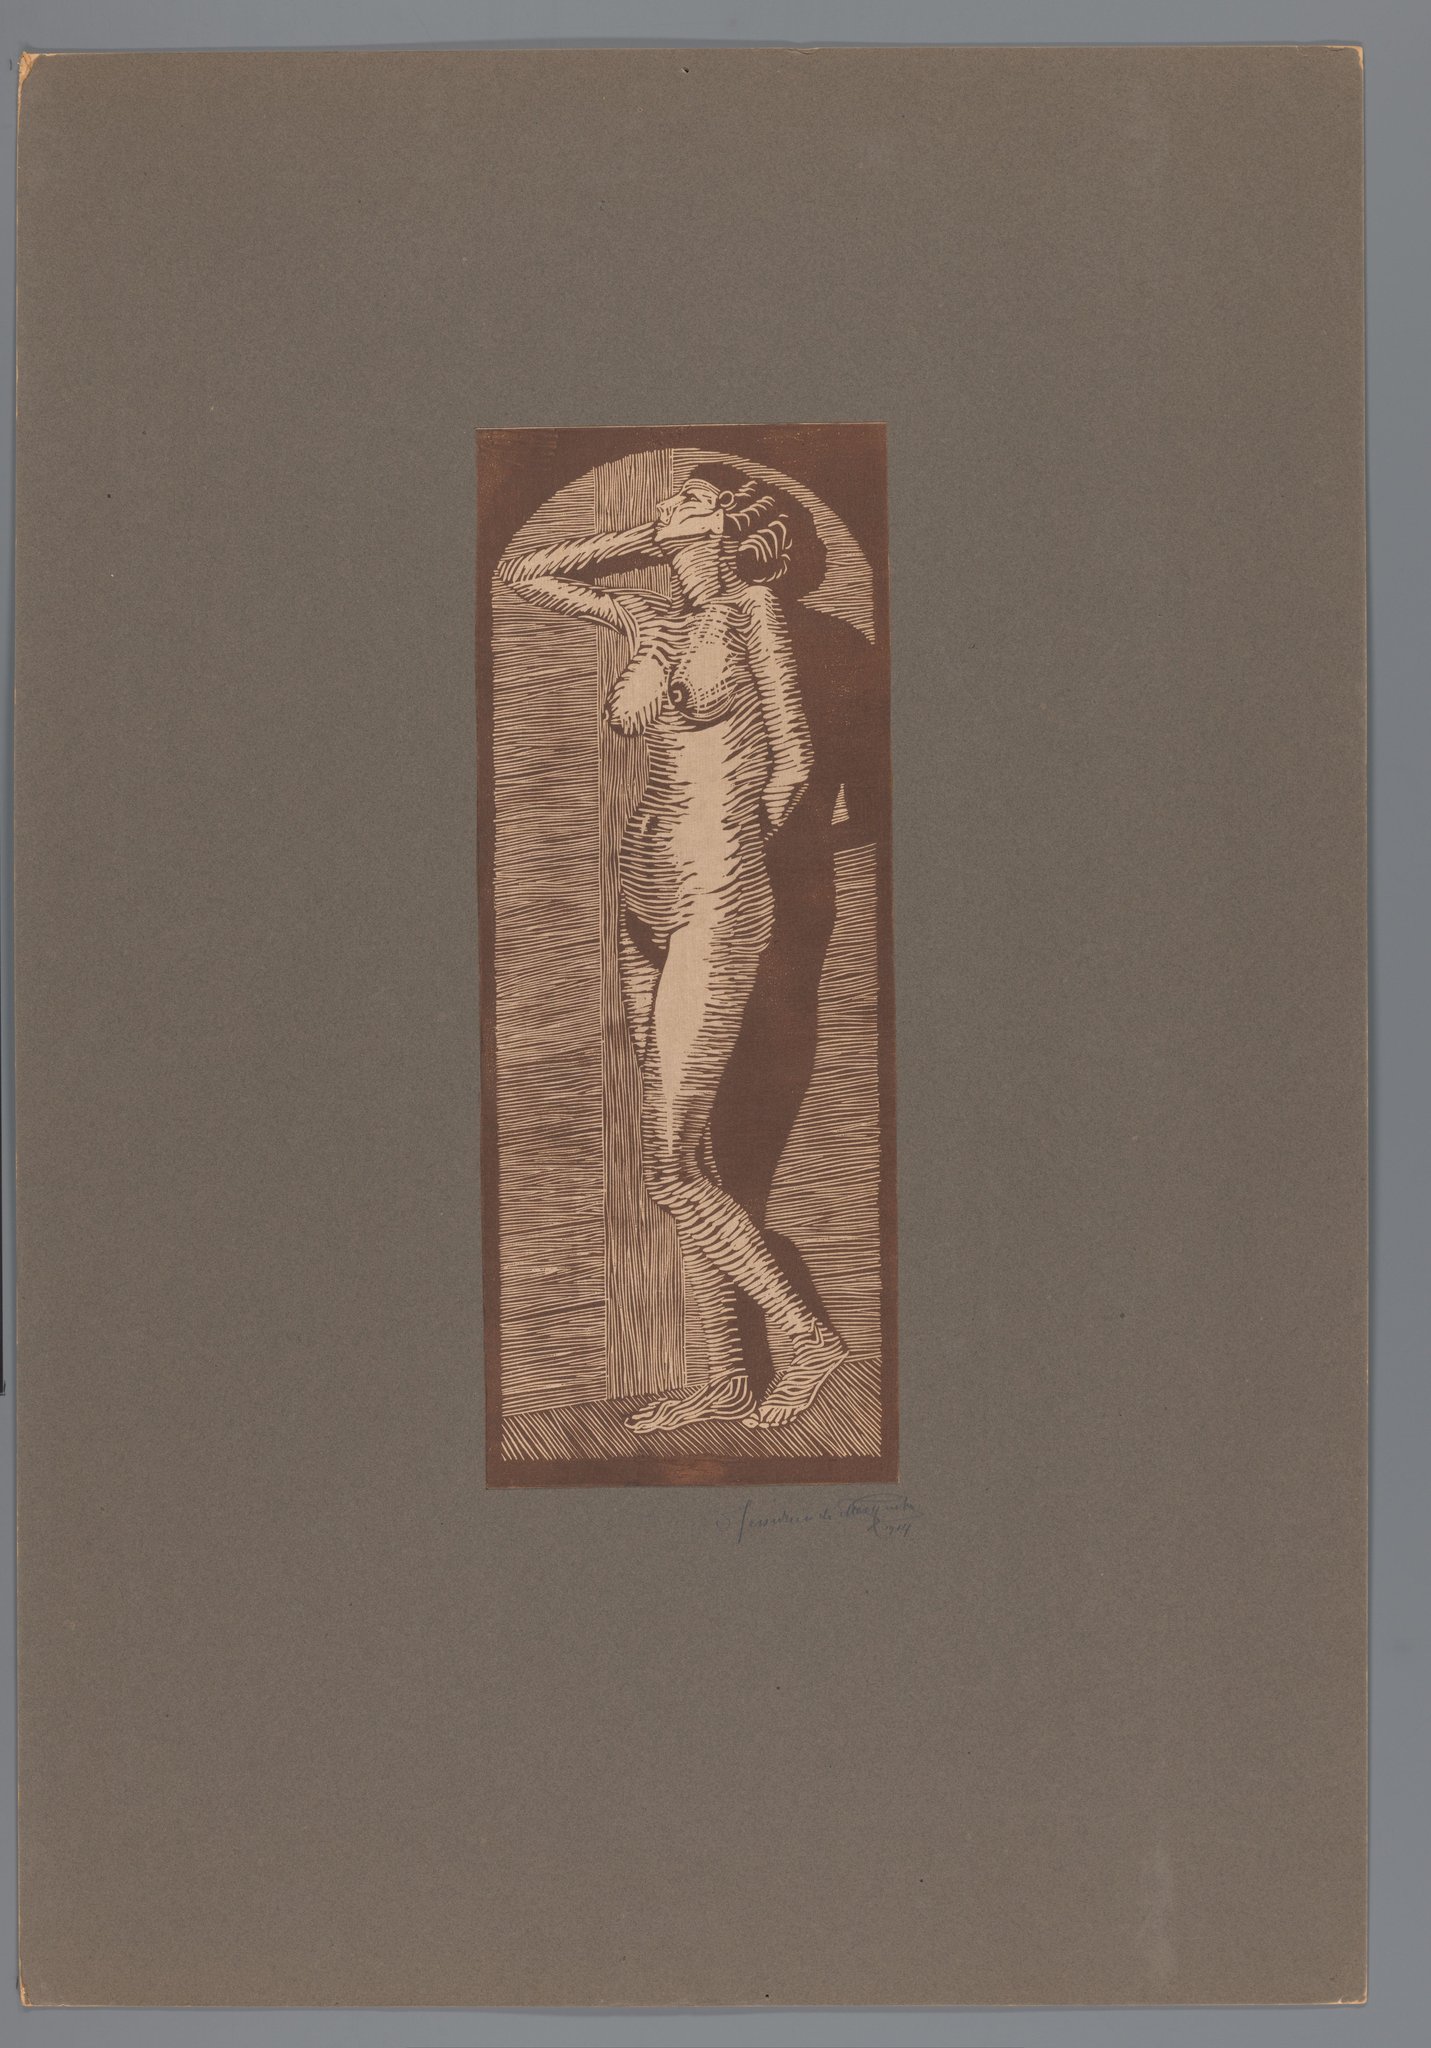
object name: print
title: Vreugde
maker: samuel jessurun de mesquita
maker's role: draughtsman, print maker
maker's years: 1868-1944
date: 1914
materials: paper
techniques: woodcut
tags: pleasure, enjoyment, joy; 'allegrezza', 'allegrezza da le medaglie', 'allegrezza, letitia e giubilo', 'diletto', 'piacere', 'piacere honesto' (ripa), the (nude) human figure; 'corpo humano' (ripa) - aa - female human figure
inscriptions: collector's mark: Lugt 2233